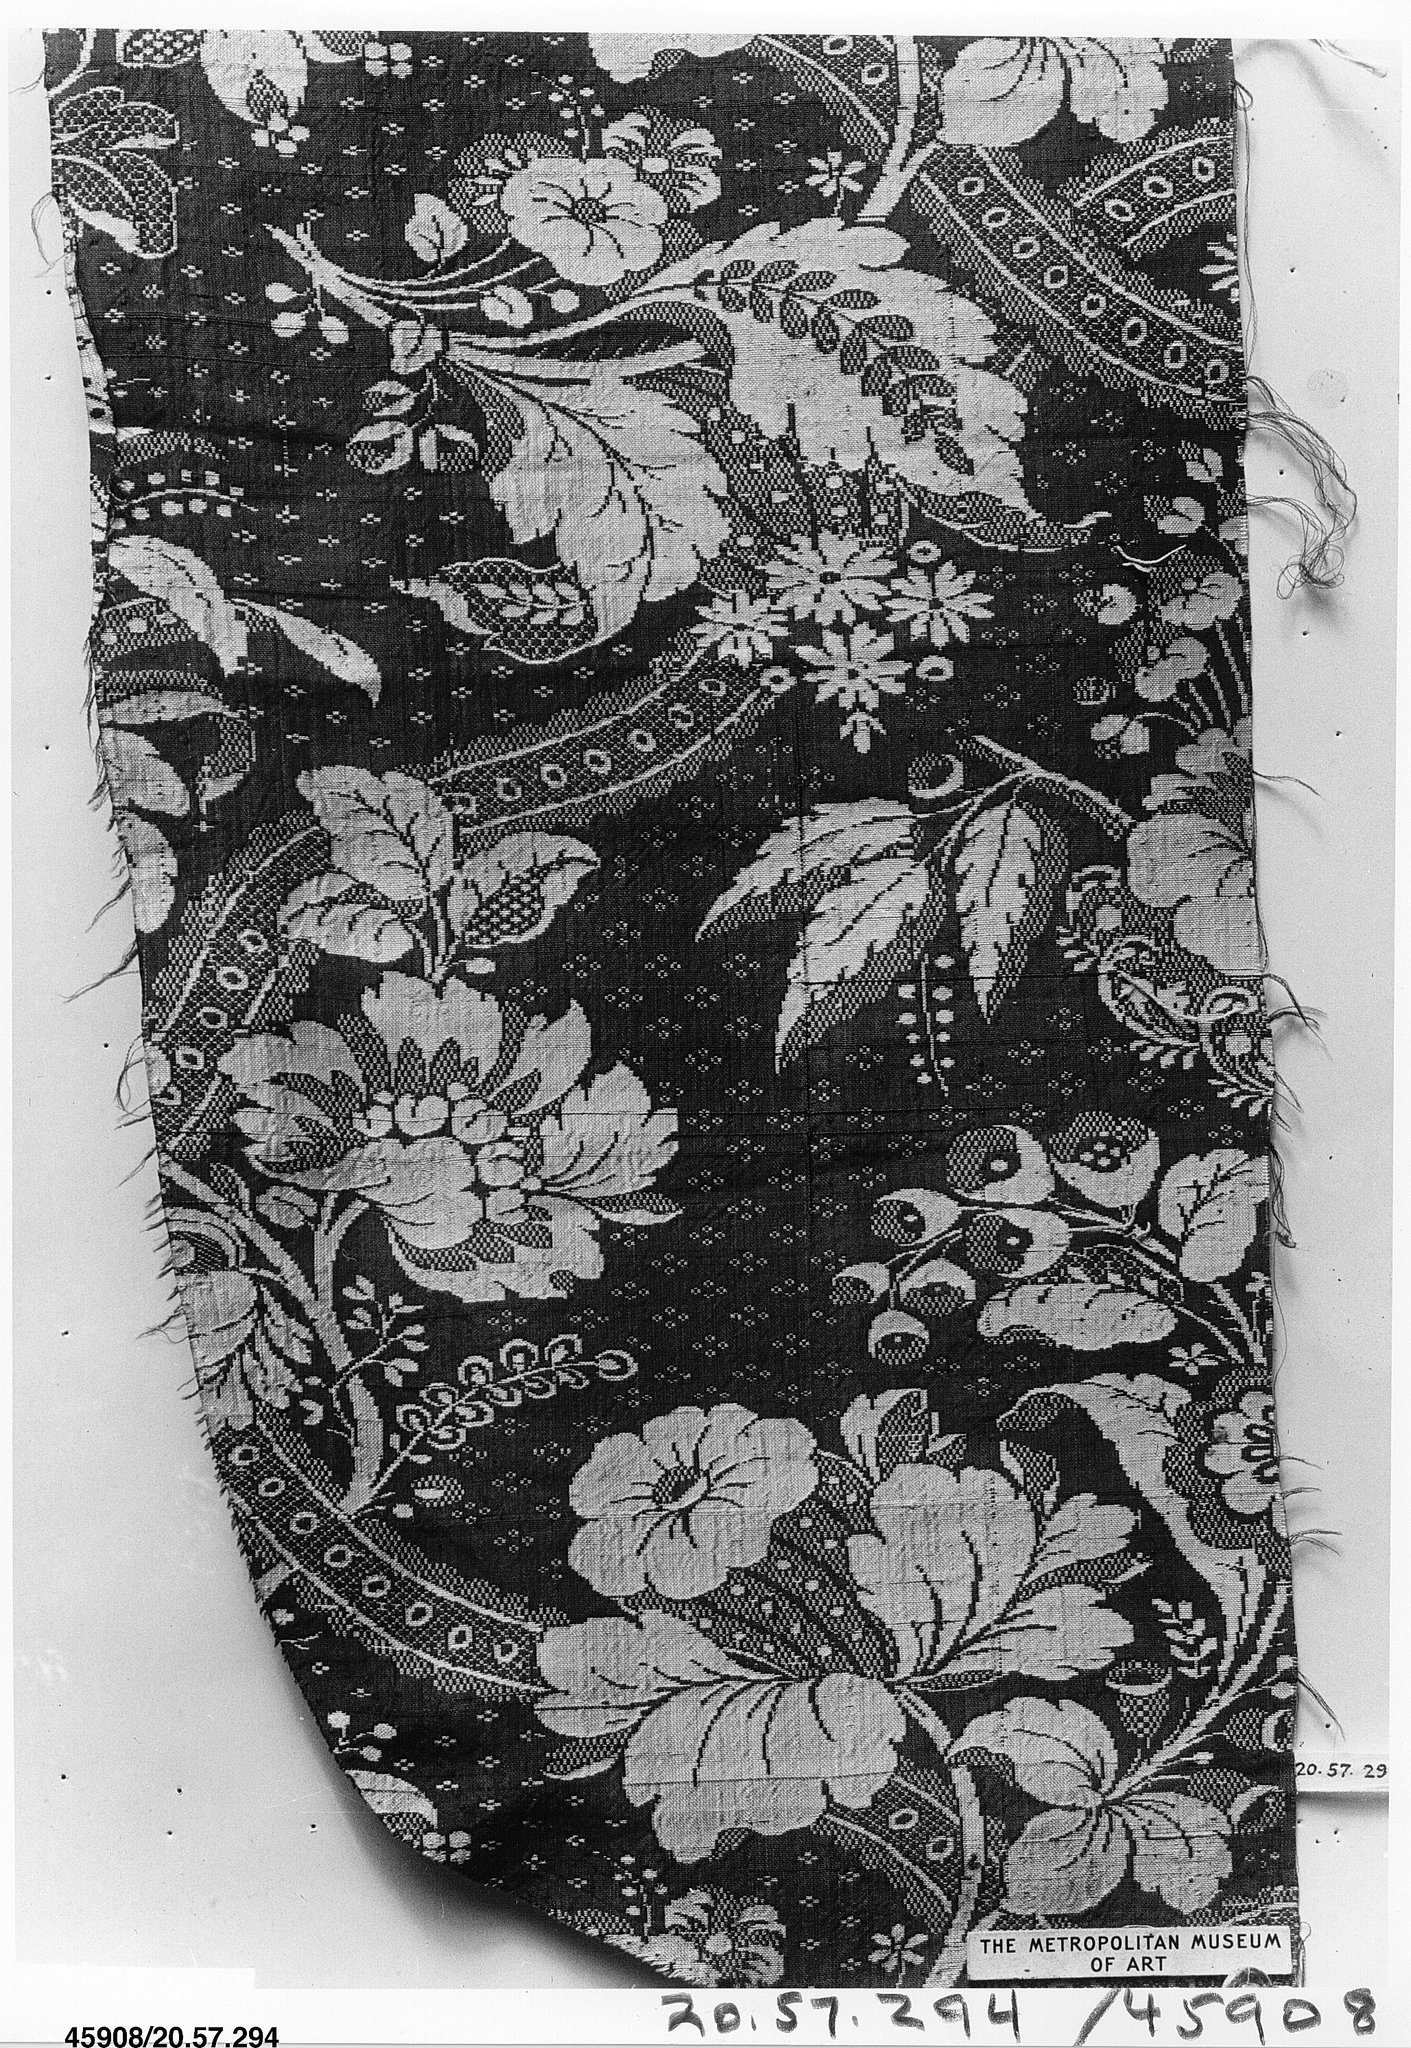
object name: piece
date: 1750-1760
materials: silk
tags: flowers,leaves